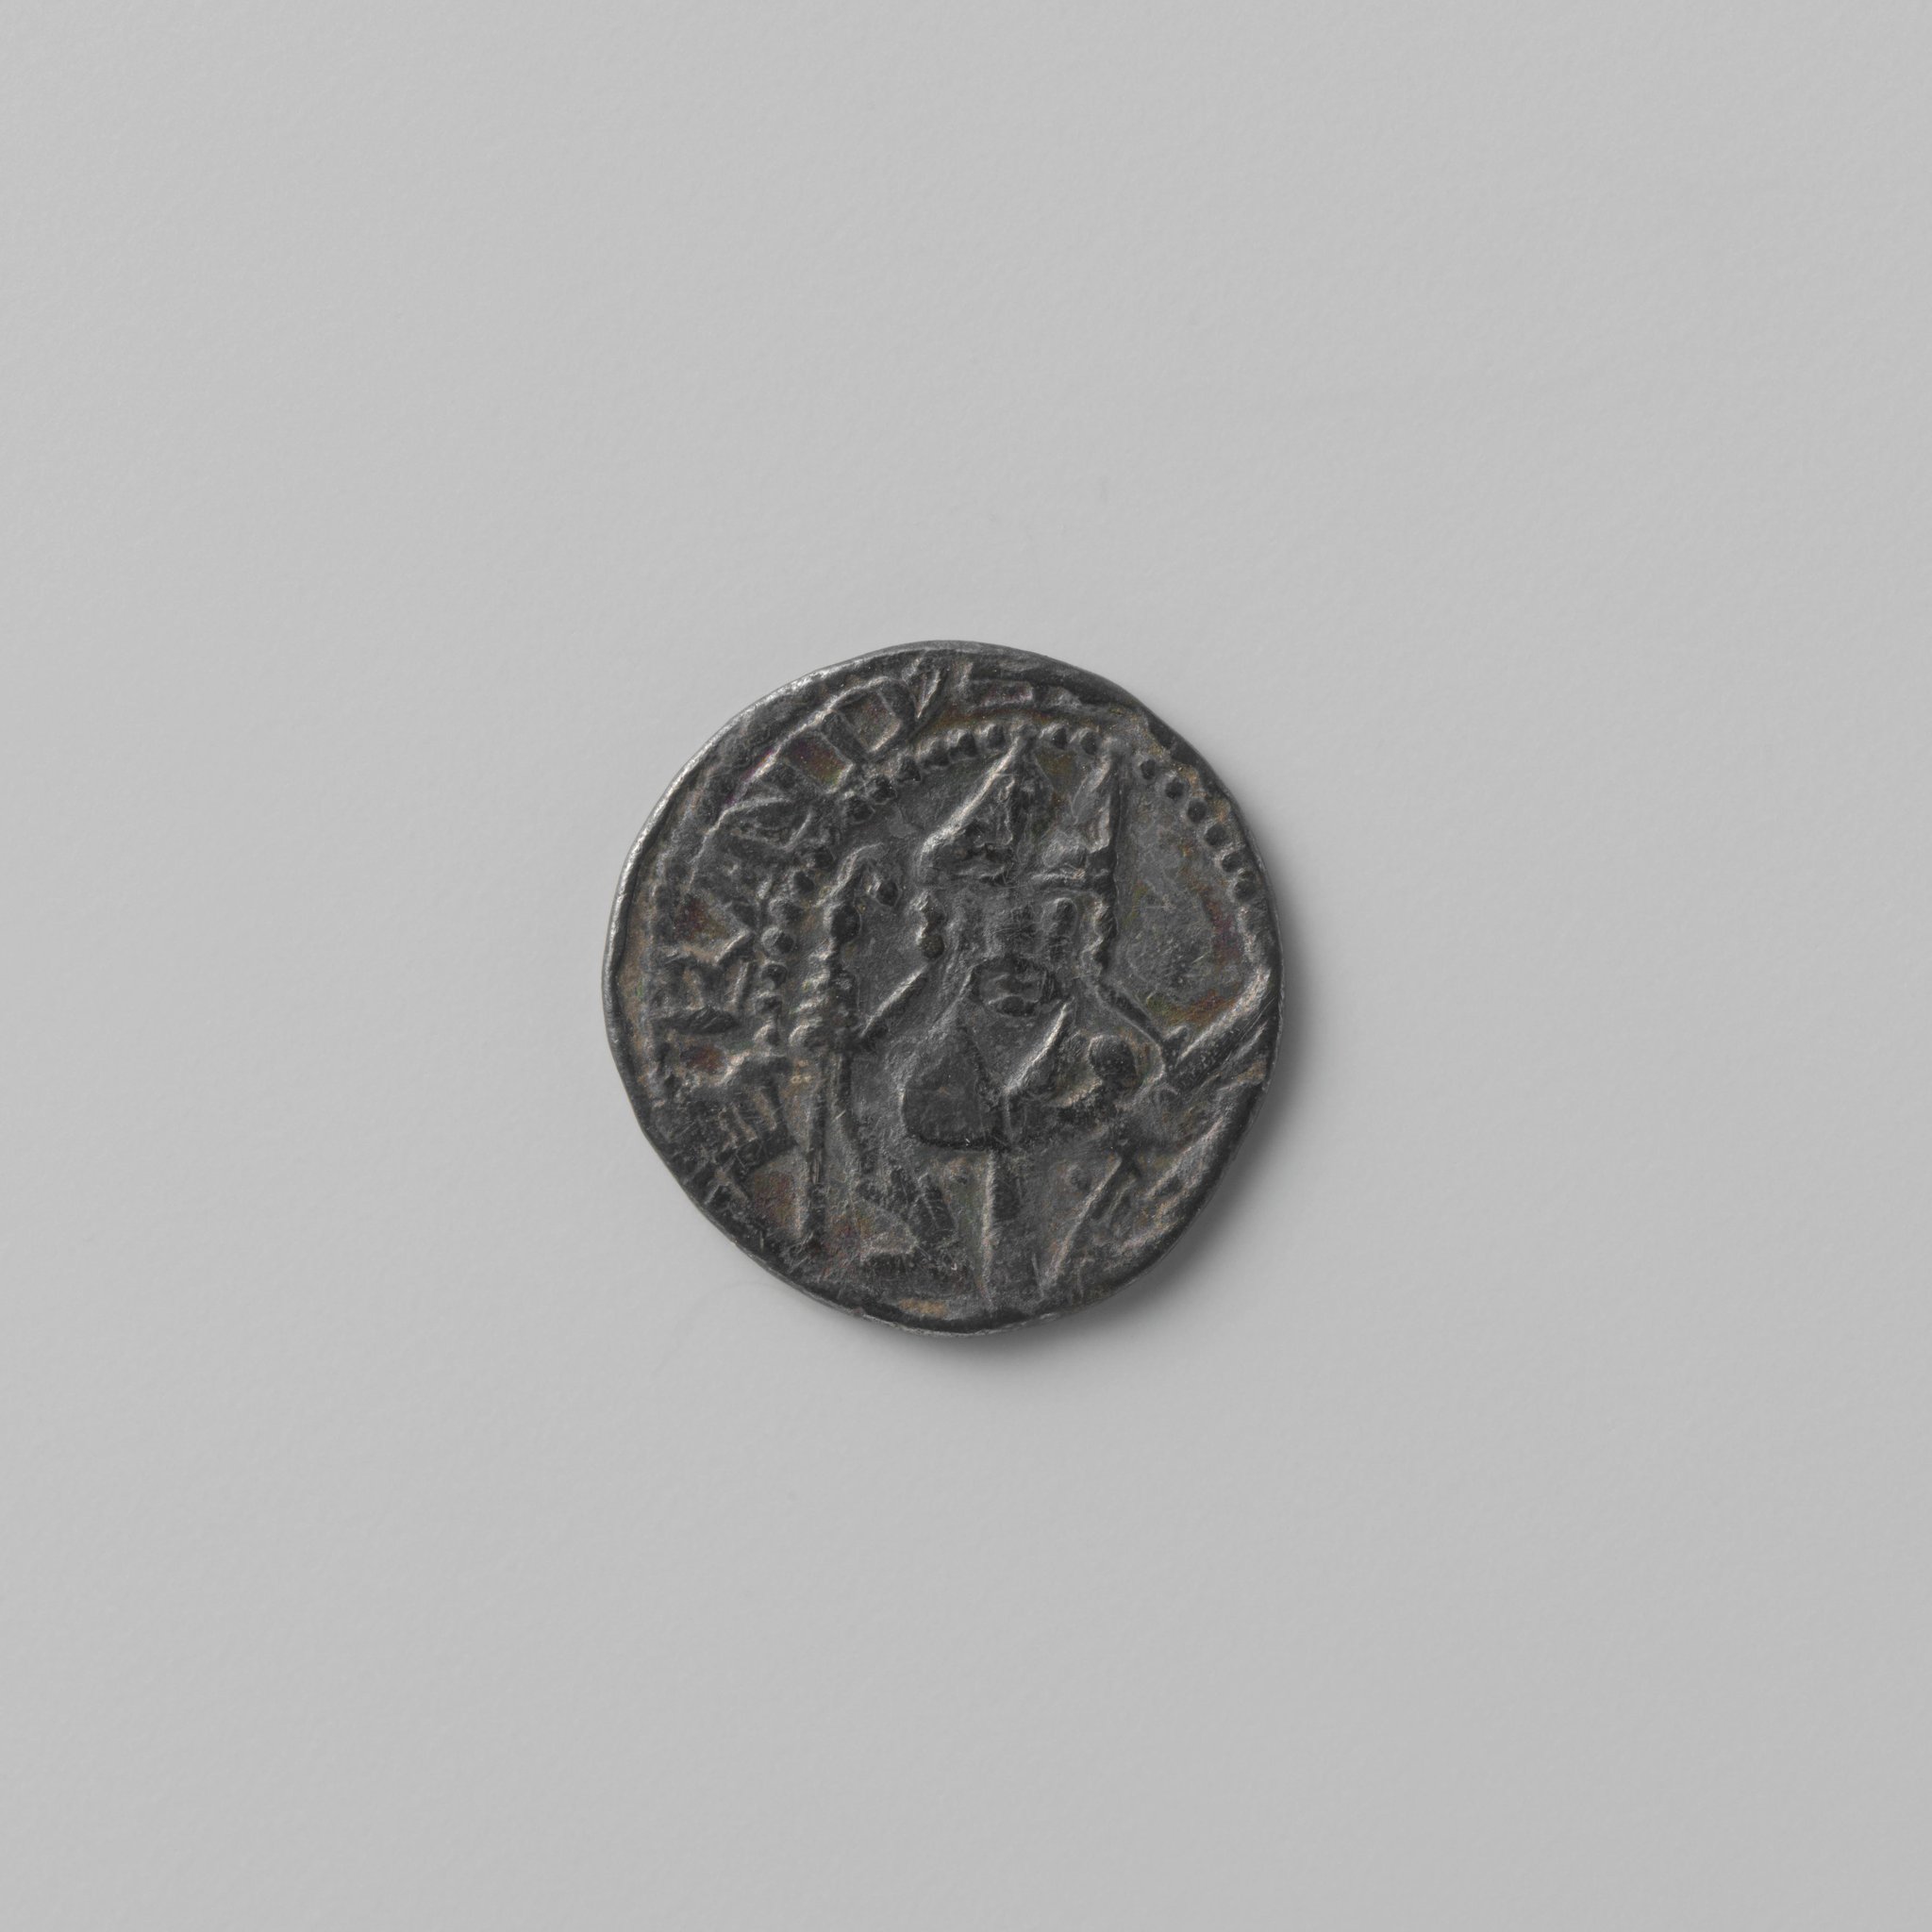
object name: coin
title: Utrecht, Willbrand van Oldenburg, penning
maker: wilbrand van oldenburg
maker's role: bisschop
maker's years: 1180-1233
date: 1227-1234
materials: silver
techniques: striking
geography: utrecht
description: Zilveren munt. Voorzijde: portret van de bisschop van voren met mijter met in rechterhand bisschopsstaf. Keerzijde: kort herkruist kruis, in hoeken puntjes.